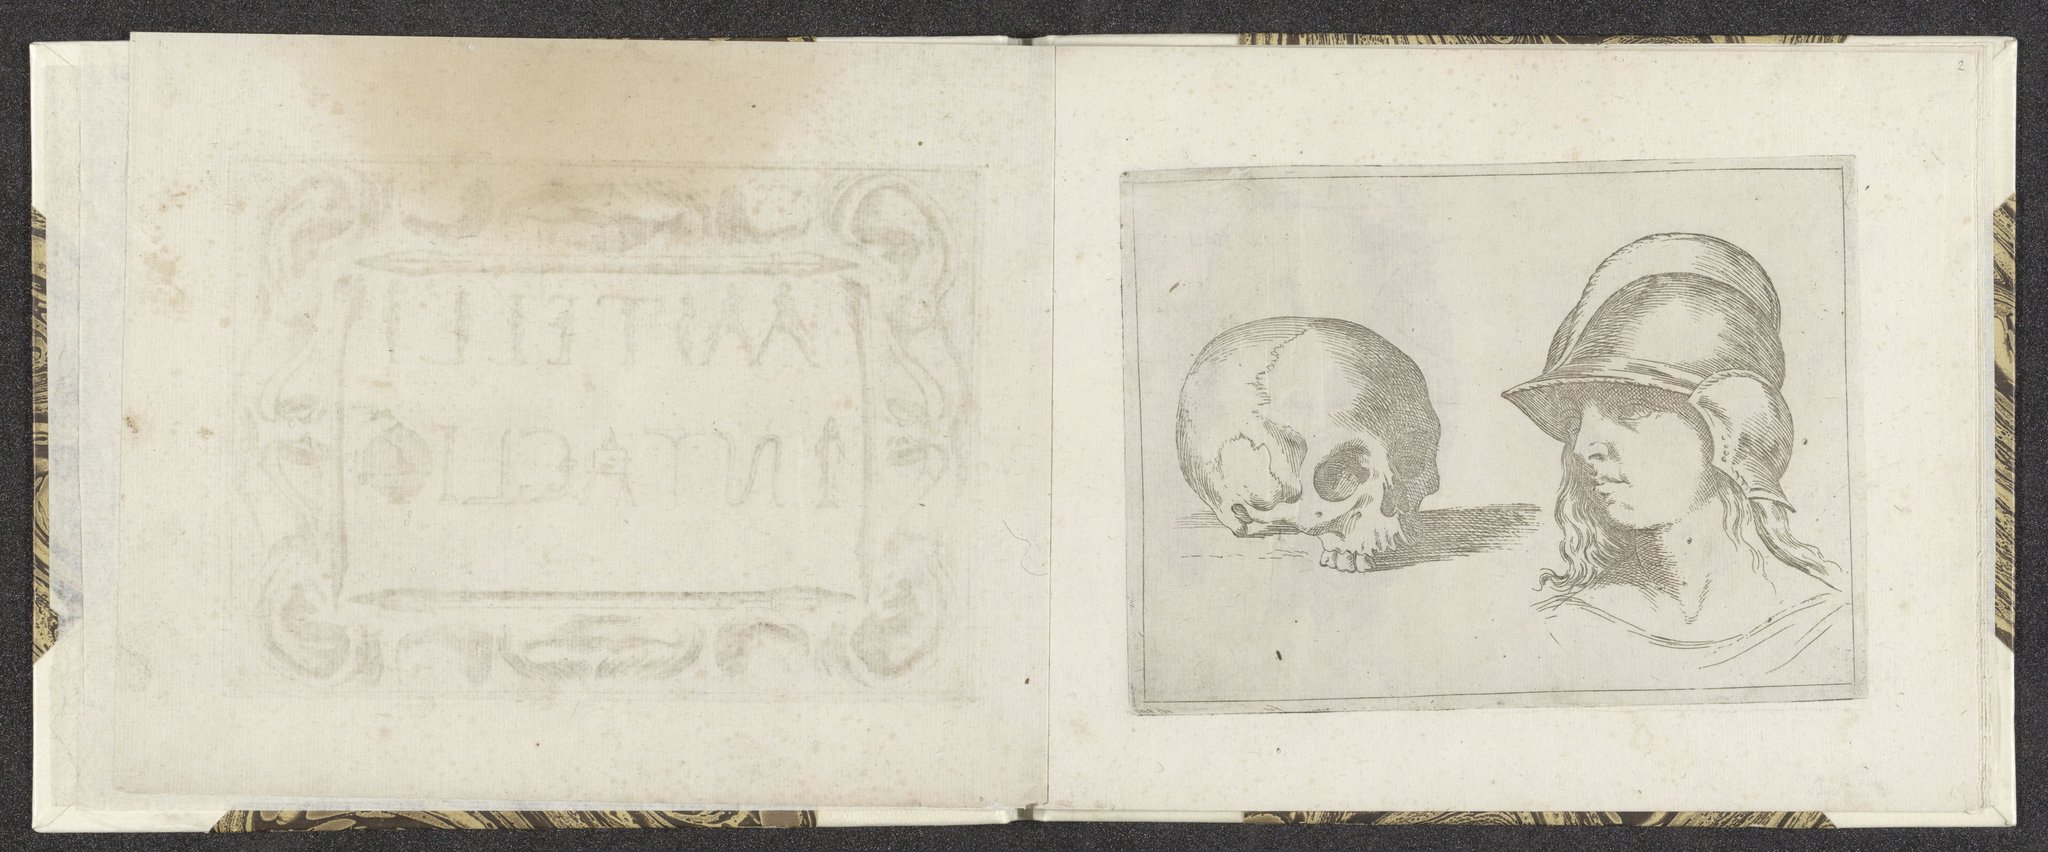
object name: album leaf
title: Schedel en een hoofd van een jongeling met helm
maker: giuseppe maria mitelli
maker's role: draughtsman, painter, print maker, publisher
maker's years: 1634-1718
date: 1663-1666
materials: paper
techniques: etching, intaglio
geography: bologna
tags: helmet, model-books ~ implements of painter, (human) skull, youth, adolescent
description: Prent komt gedeeltelijk overeen met de beschrijving door Bertarelli van catalogusnummer 140. In deze prent ontbreekt echter het door hem beschreven oog.